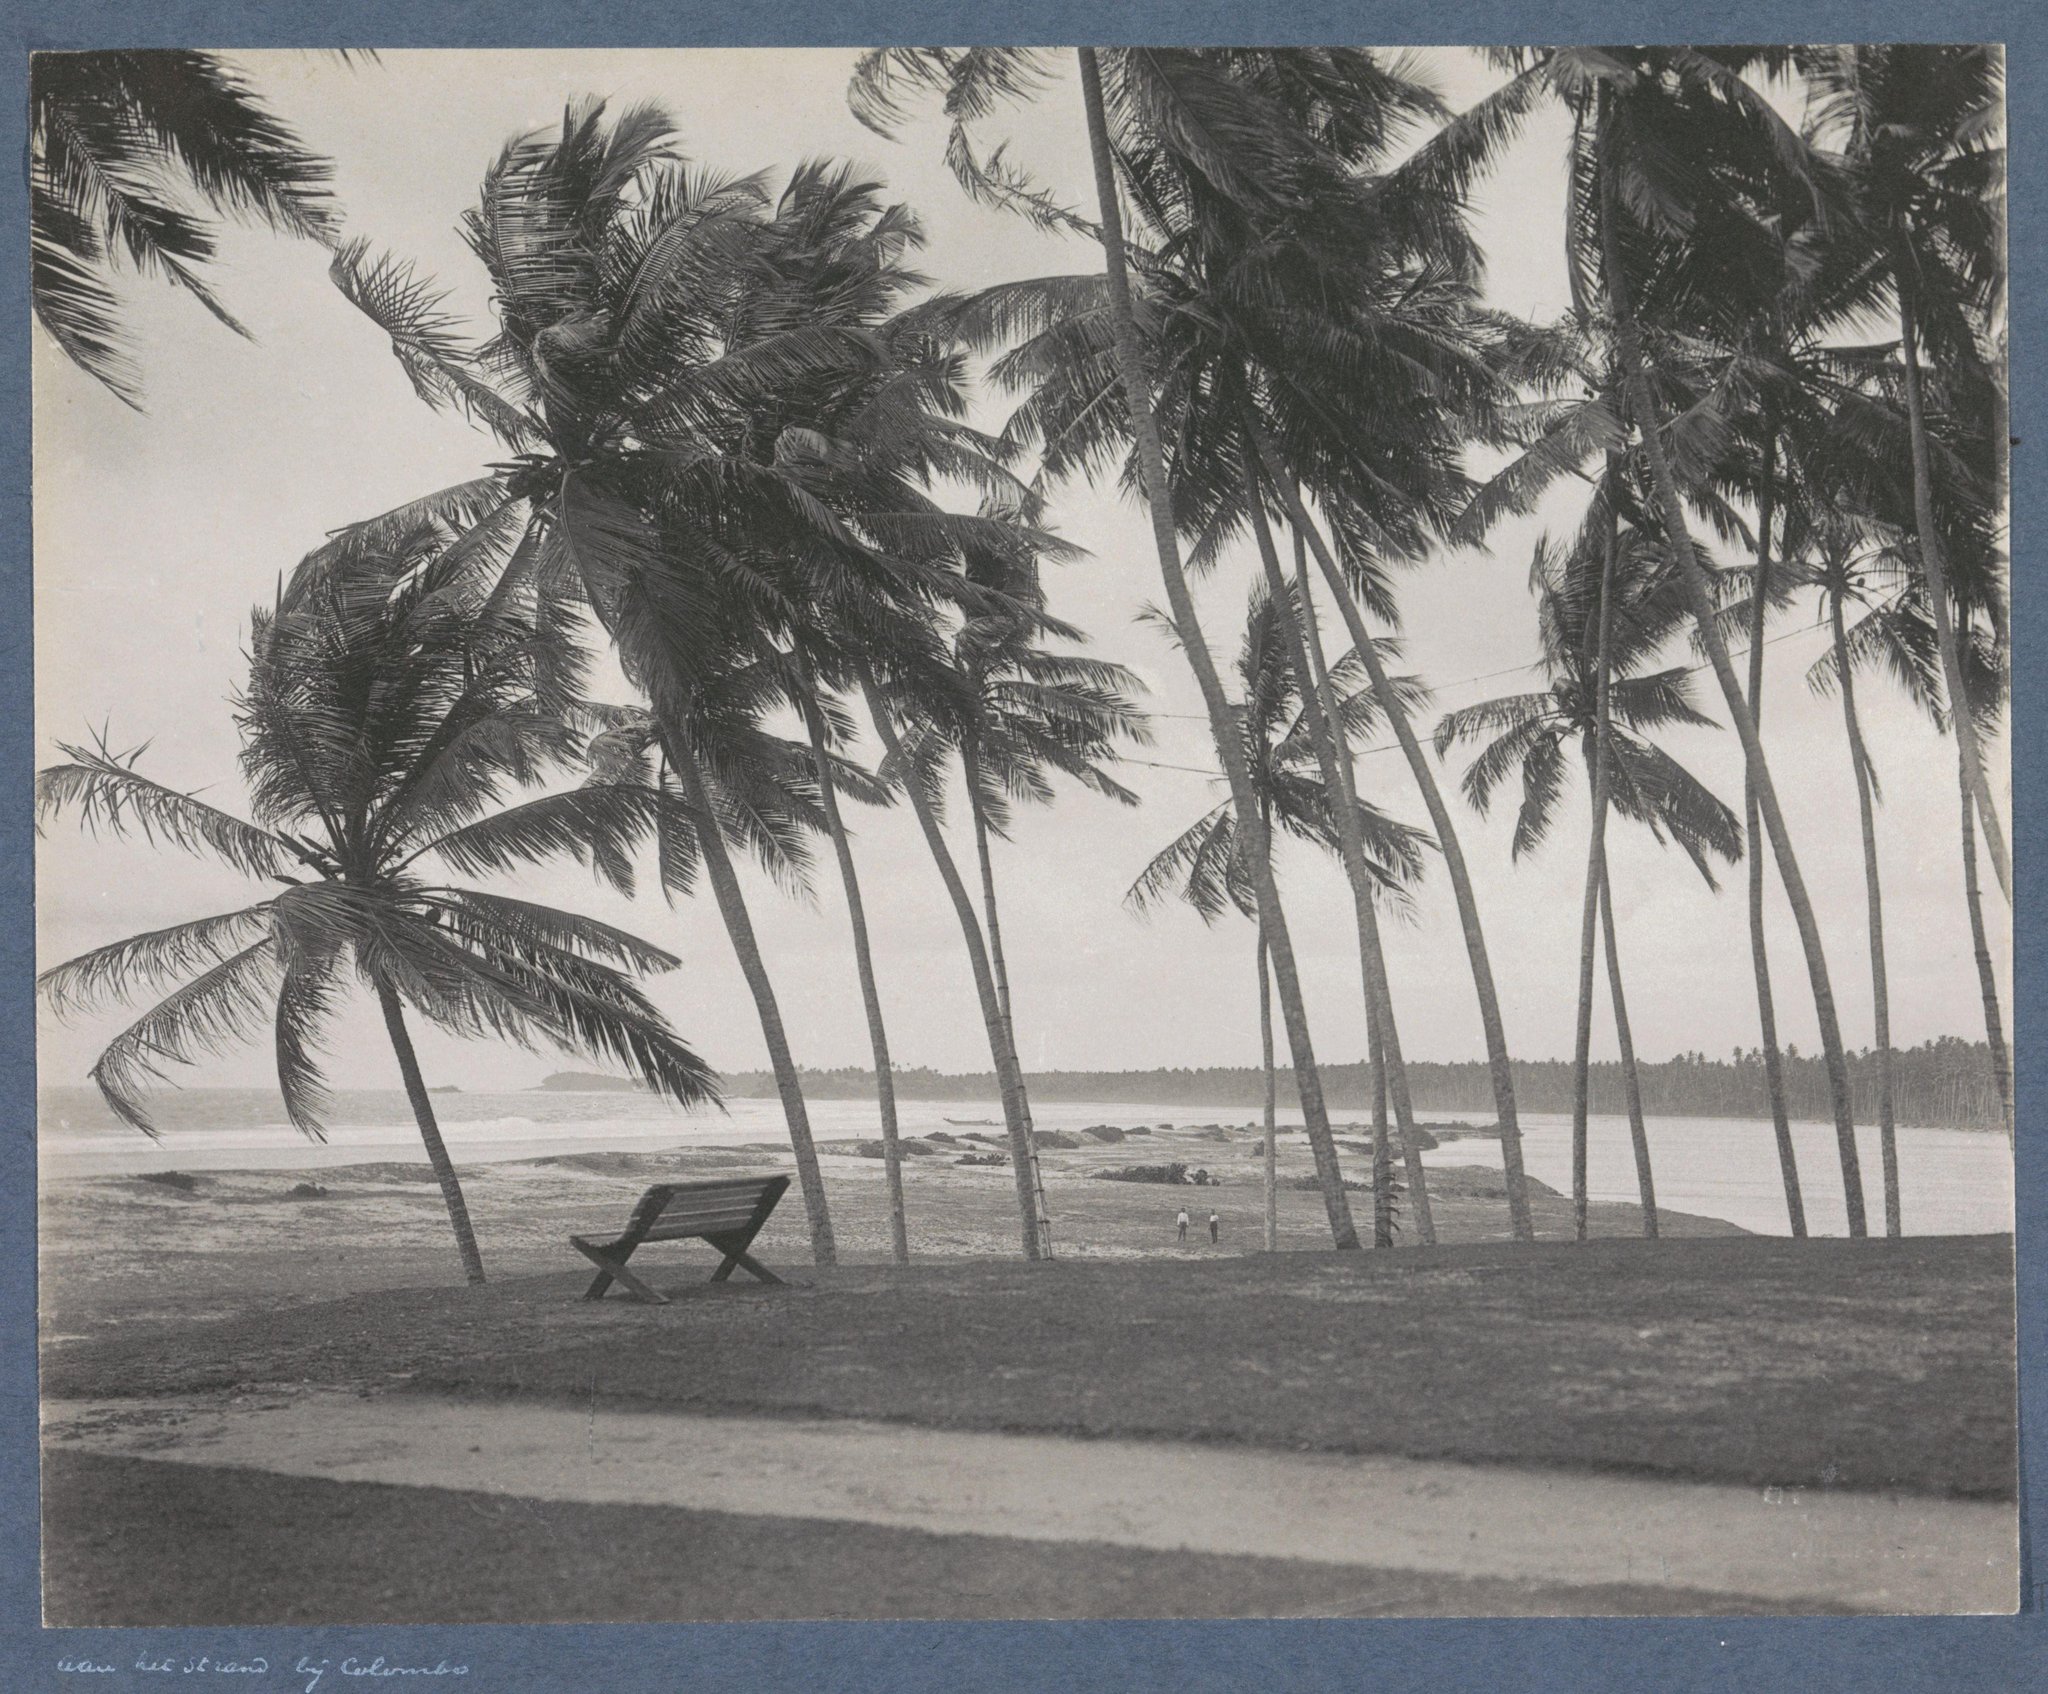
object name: photograph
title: Strand bij Colombo (Ceylon) met palmen en bank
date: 1900-1920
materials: paper, photographic support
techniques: platinum process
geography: colombo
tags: trees: palm-tree, beach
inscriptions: name: ‘Plate Ltd. Ceylon copy right’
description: Onderdeel van reisalbum met foto's van bedrijvigheid en bezienswaardigheden op Sumatra en Java en van de reis naar en van Nederlands-Indië.